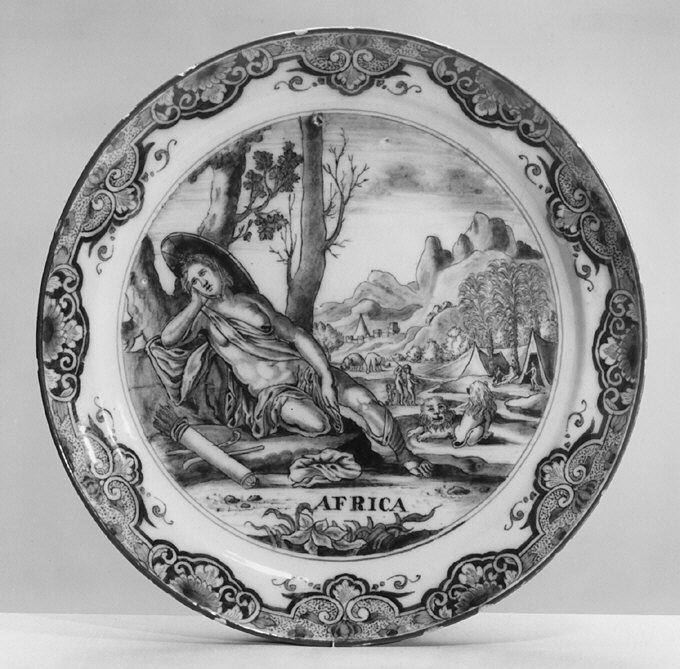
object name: plate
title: Africa (part of a set of four)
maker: johann sadeler (i)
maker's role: artist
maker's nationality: netherlandish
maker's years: 1550-1601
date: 1667-1733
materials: earthenware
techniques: glazing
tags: women,lions,landscapes